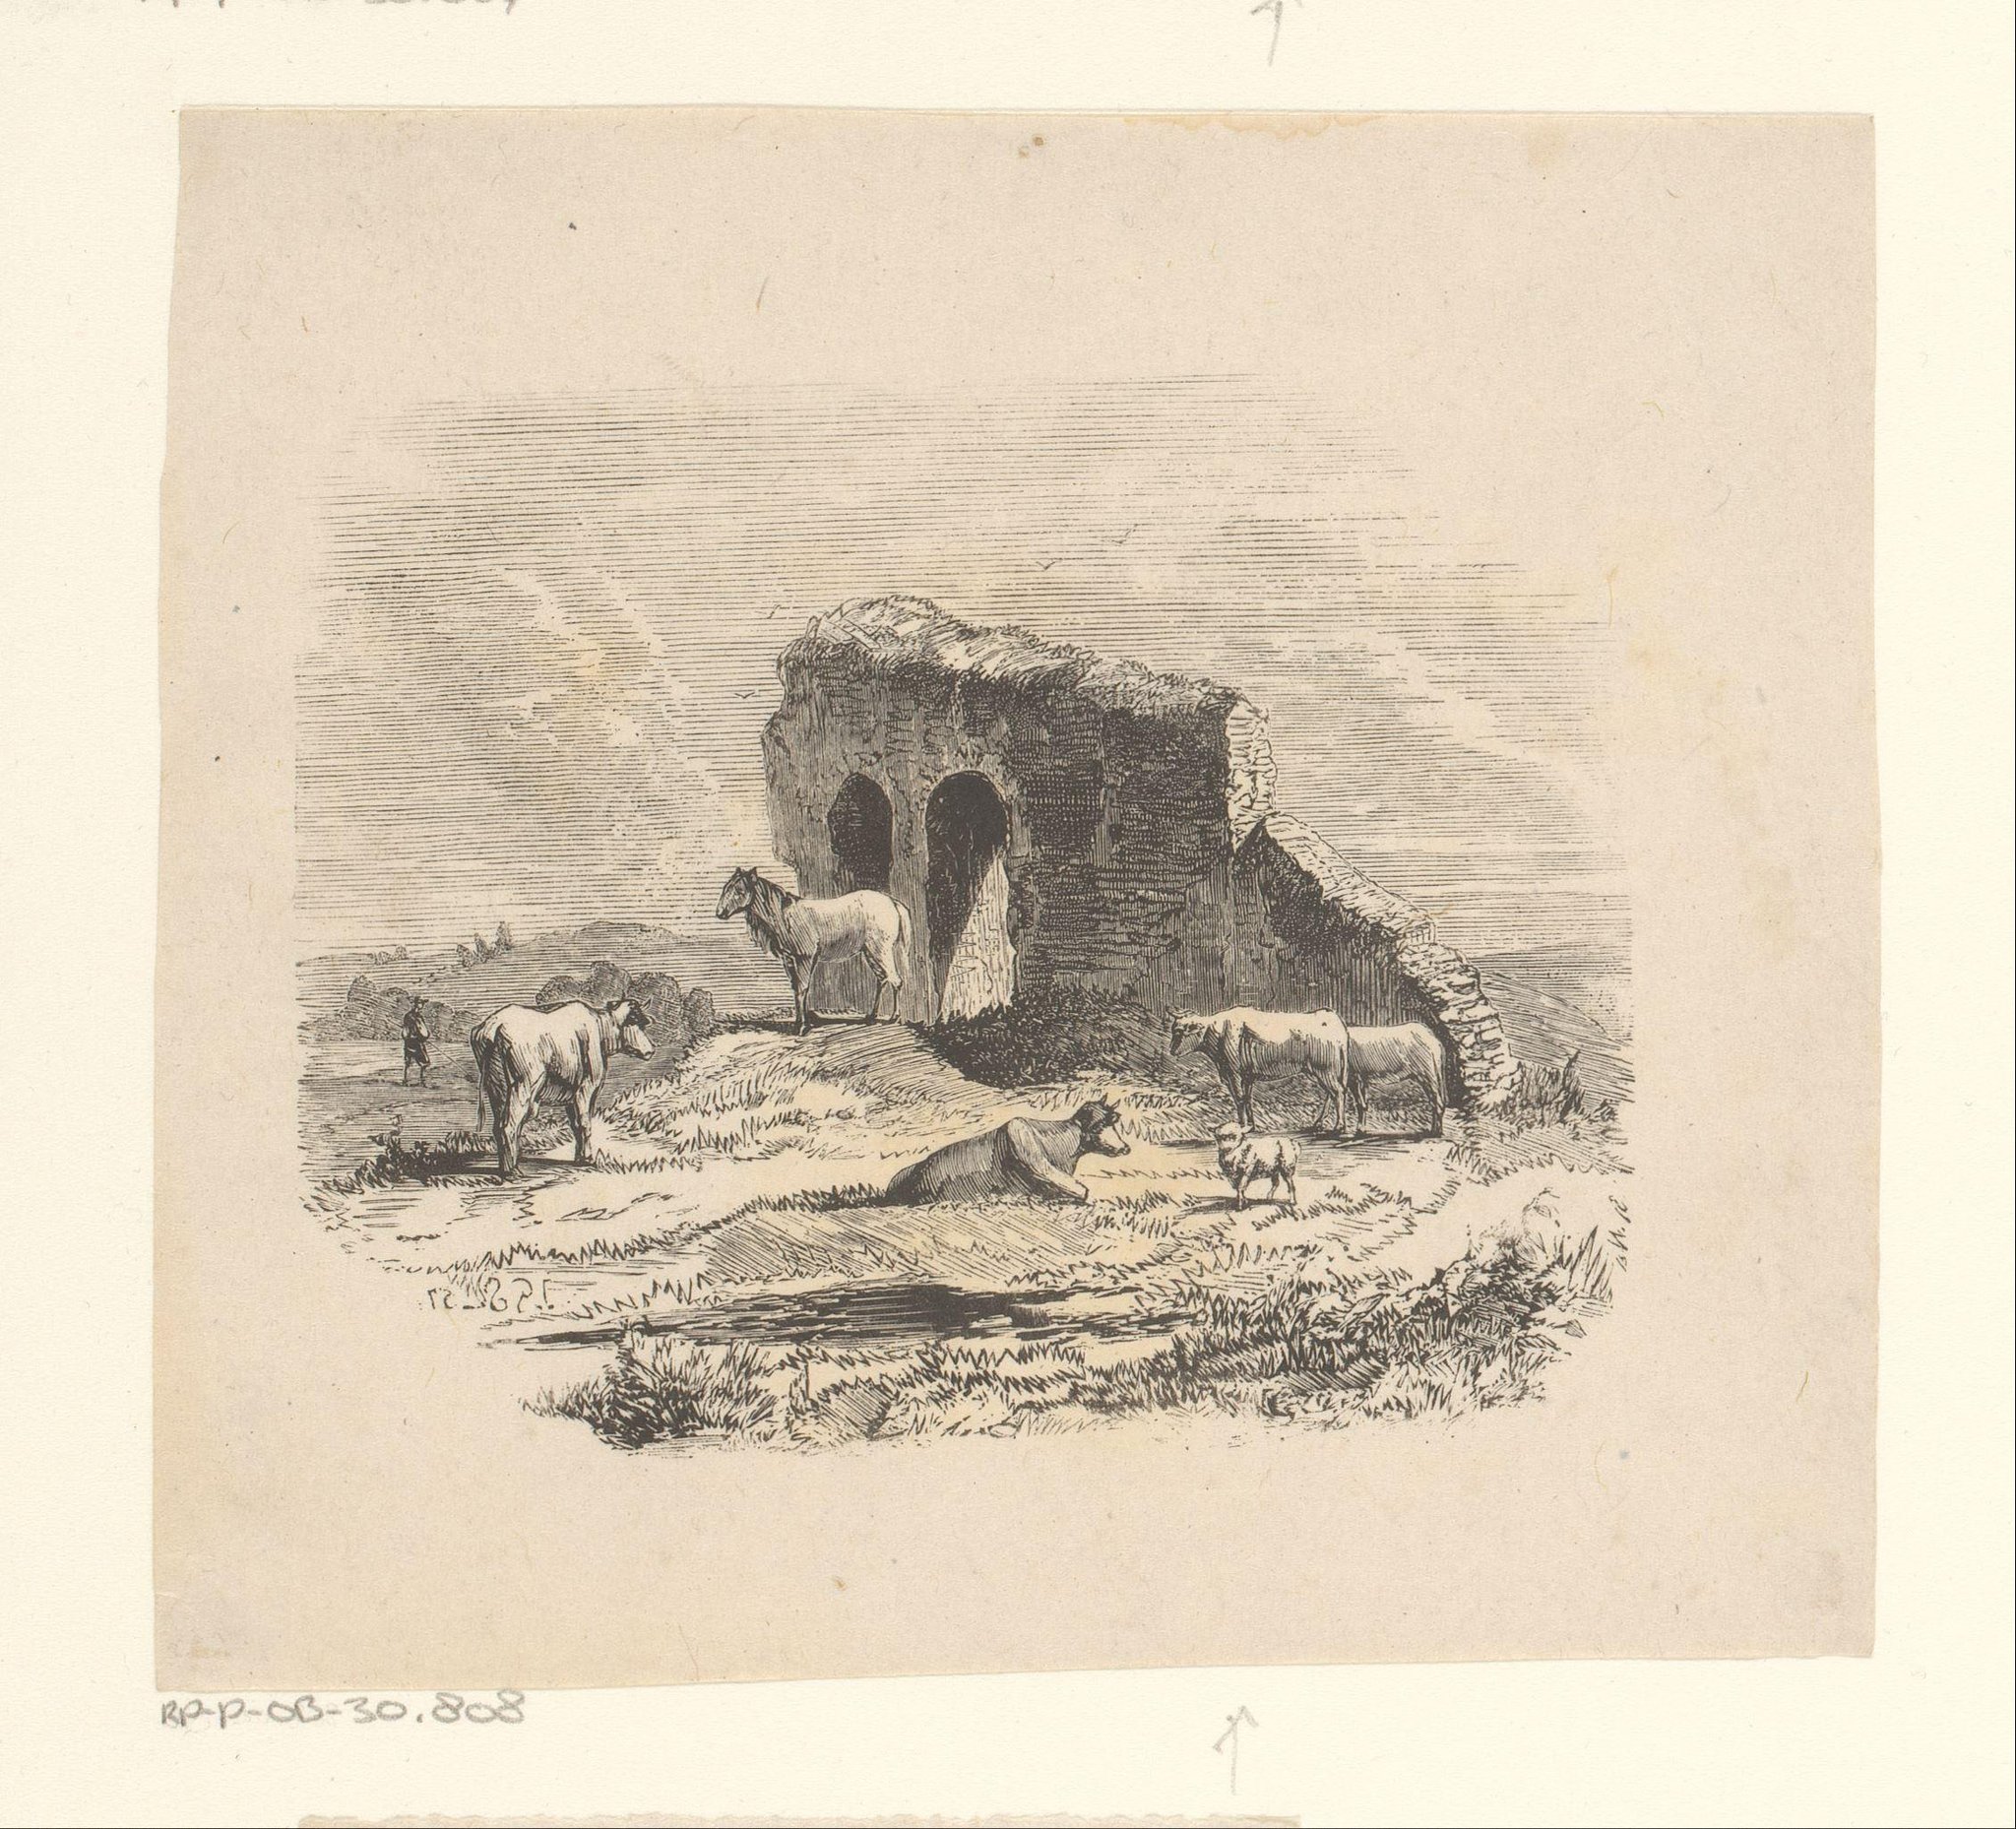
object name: print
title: Koeien, een paard en een schaap bij een ruïne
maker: isaac weissenbruch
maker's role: print maker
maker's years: 1826-1912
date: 1836-1912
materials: paper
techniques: engraving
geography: netherlands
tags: cow, lamb, horse, landscape with ruins (+ city(-scape) with figures, staffage)